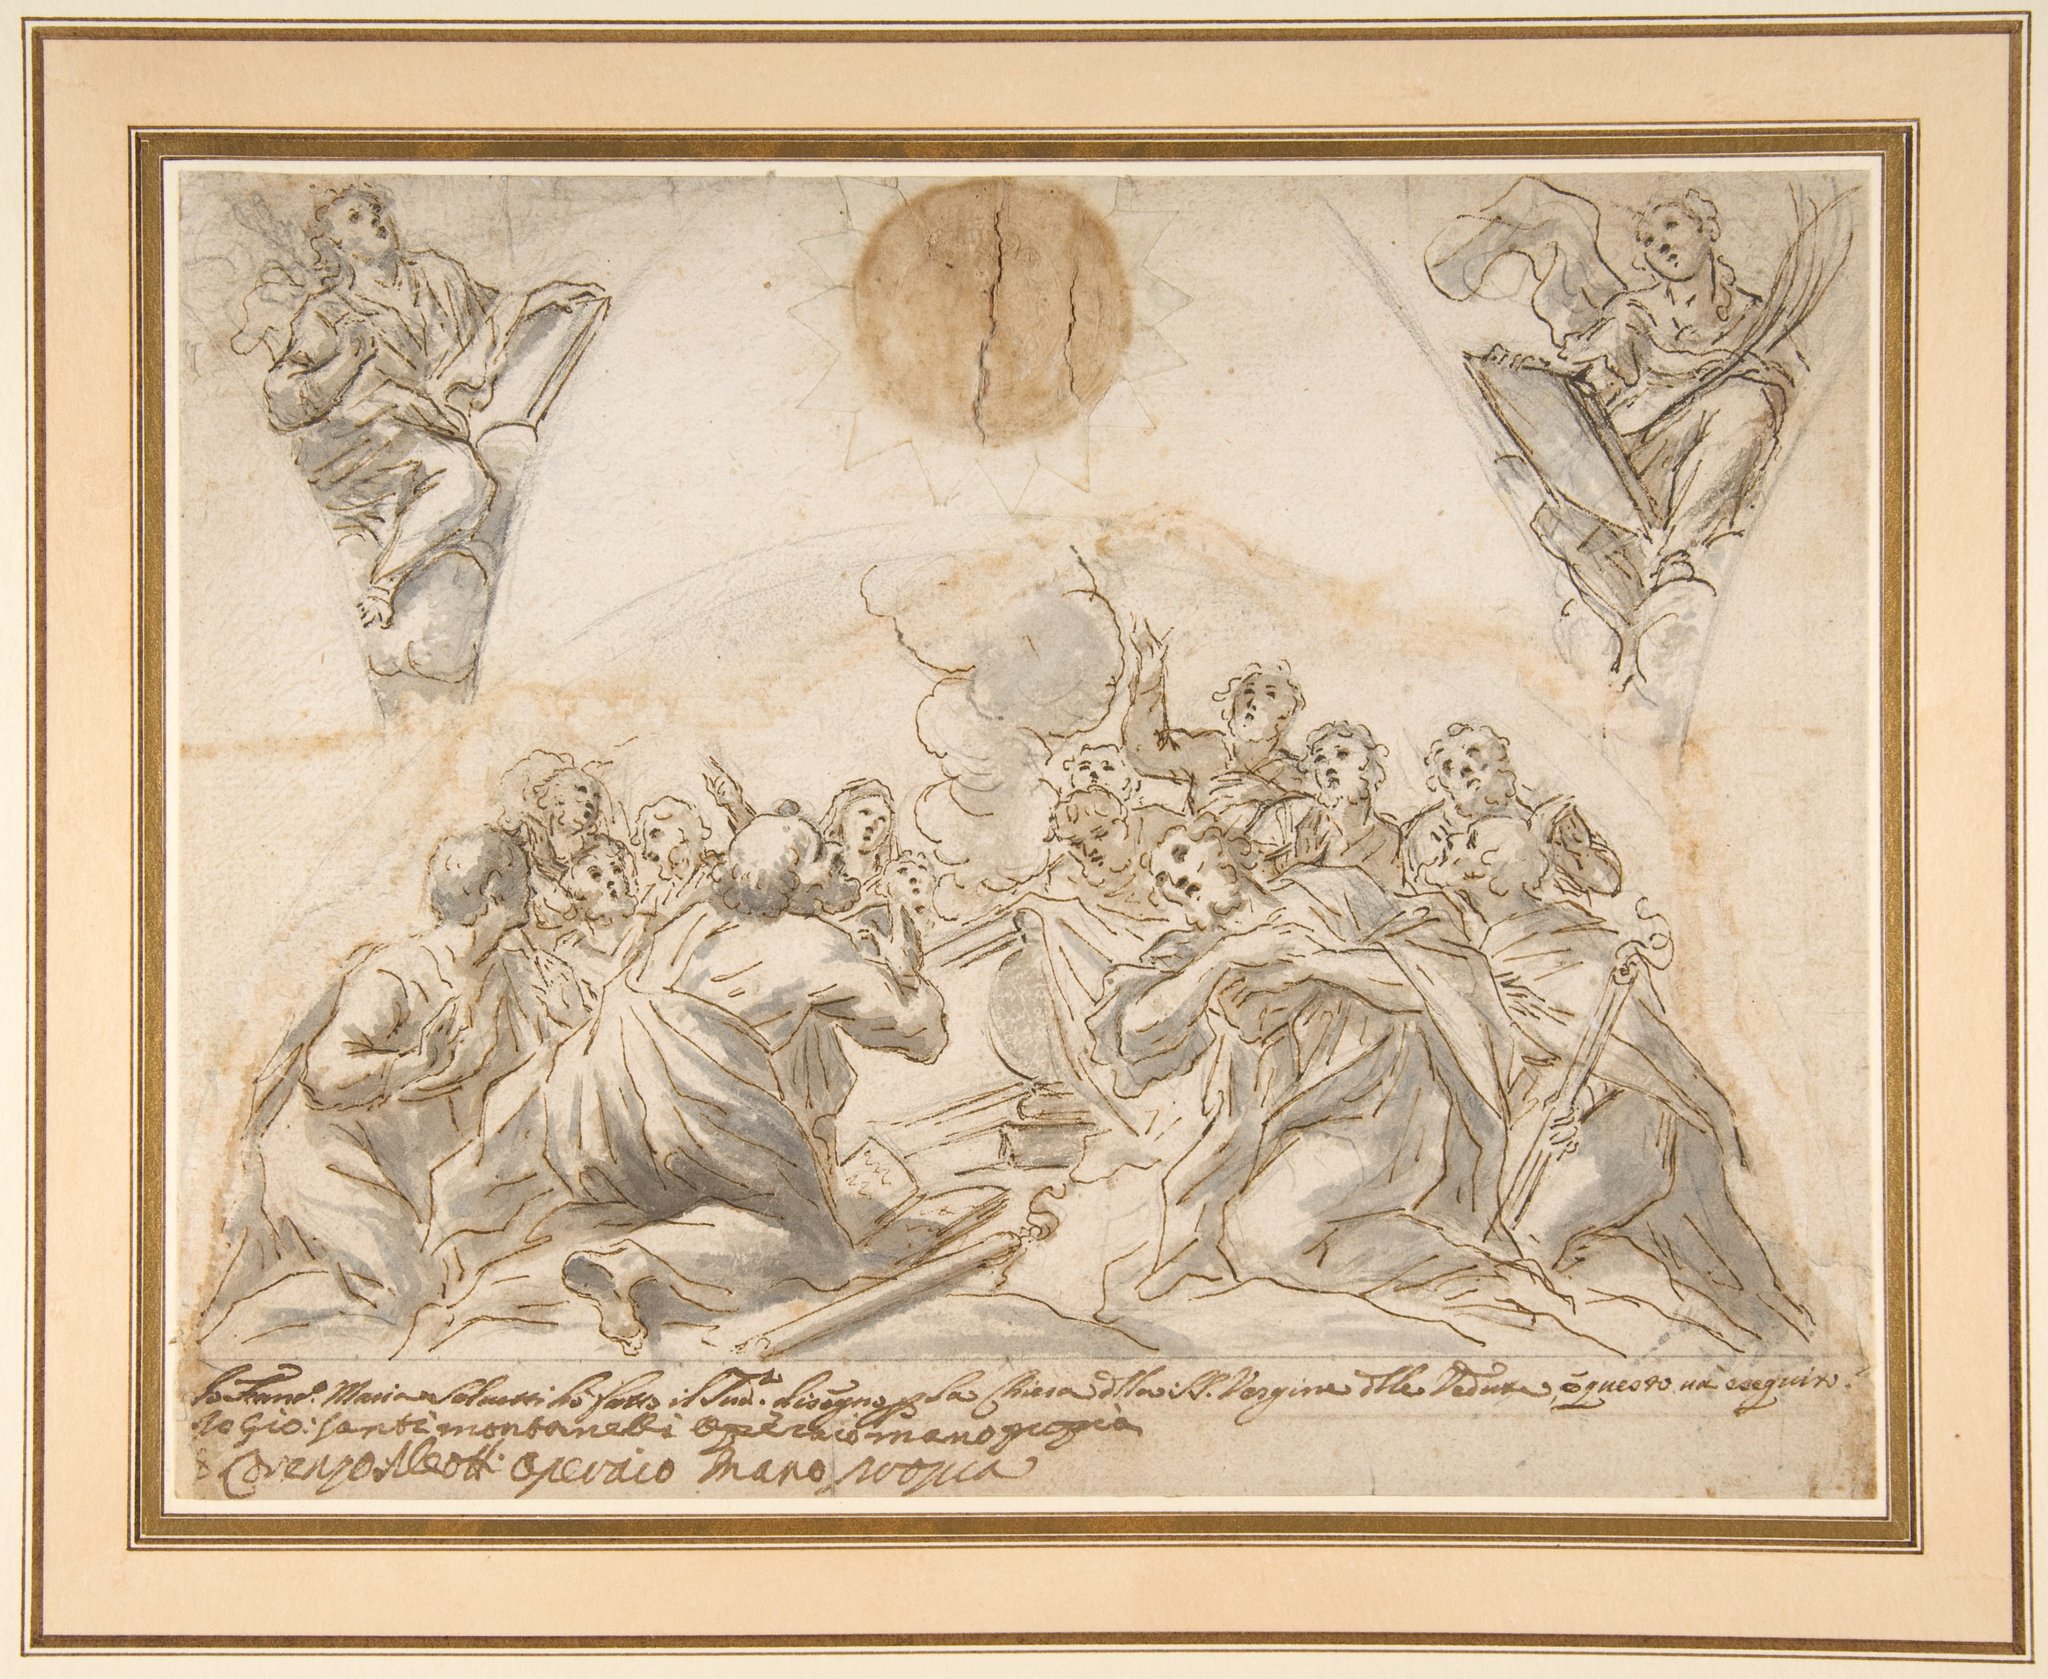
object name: drawing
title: The Apostles at the Tomb of the Virgin, and Studies for Two Pendentives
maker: francesco maria salvetti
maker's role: artist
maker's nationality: italian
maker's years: 1691-1758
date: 1691-1758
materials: chalk, ink, wax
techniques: brush, embossing, incising, pen, wash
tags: angels,apostles,virgin mary